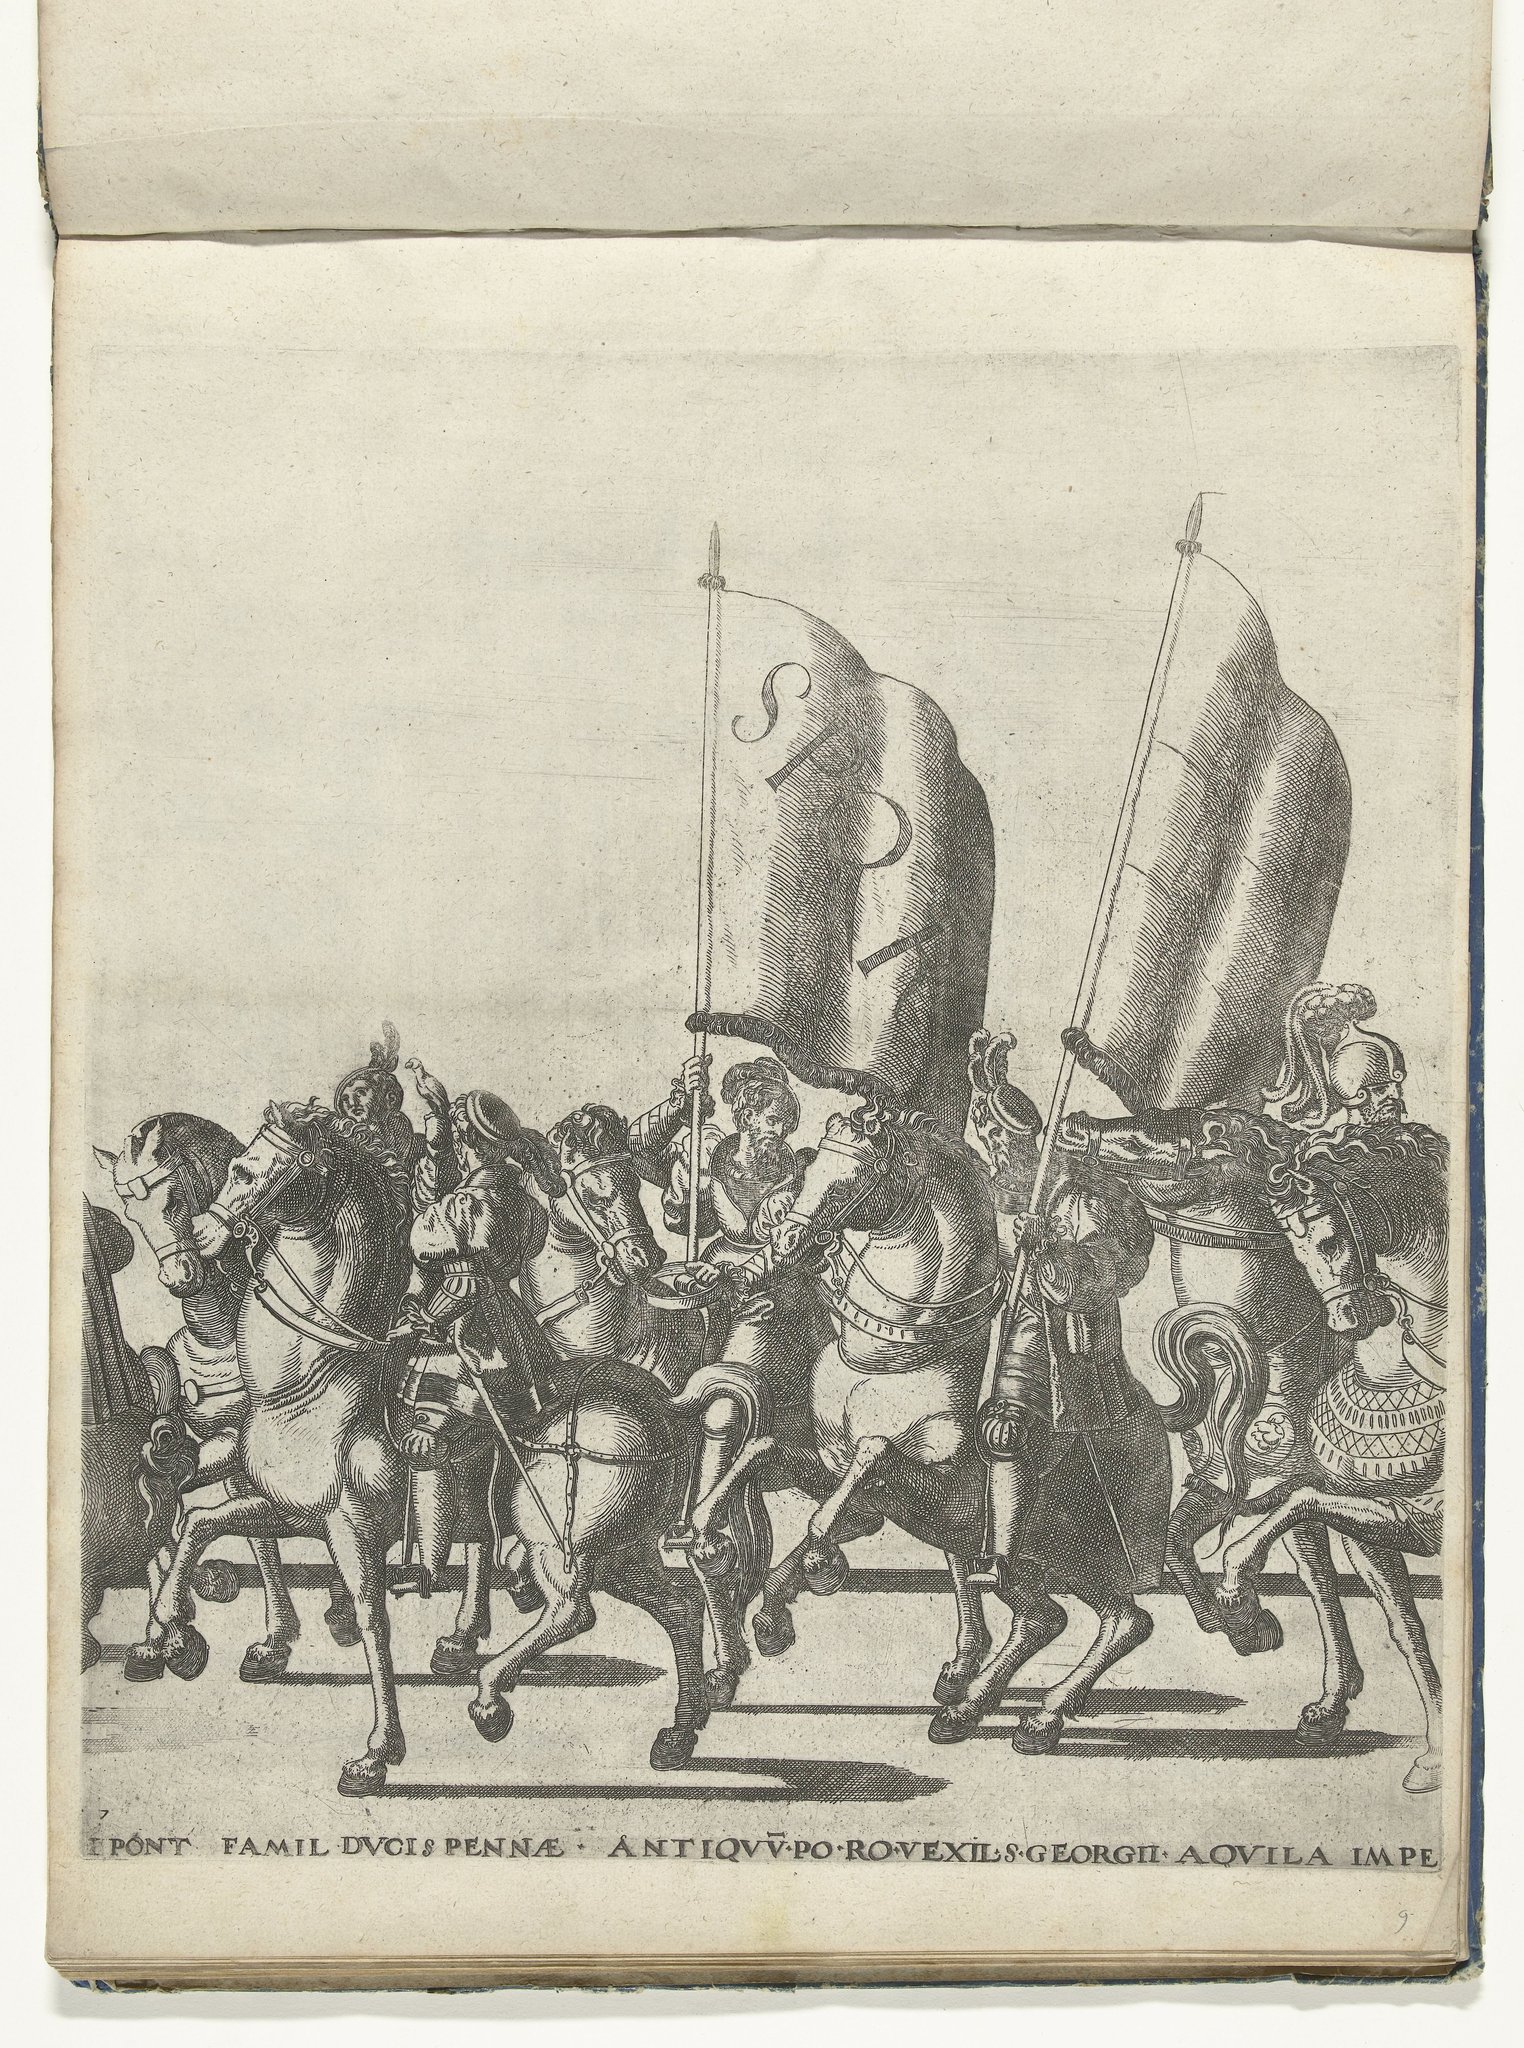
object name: print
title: Vaandeldragers SPQR, plaat 7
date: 1530-1536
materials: paper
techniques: engraving, etching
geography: mechelen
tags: ghent, charles v (holy roman emperor and king of spain), festivities (+ parade, pageant, cavalcade ~ festive activities)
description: Prent in het album waarin zijn ingeplakt de 40 platen die achterelkaar samen het fries vormen van de optocht van Karel V met de paus Clemens VII te Bologna na zijn kroning tot keizer, 24 februari 1530.